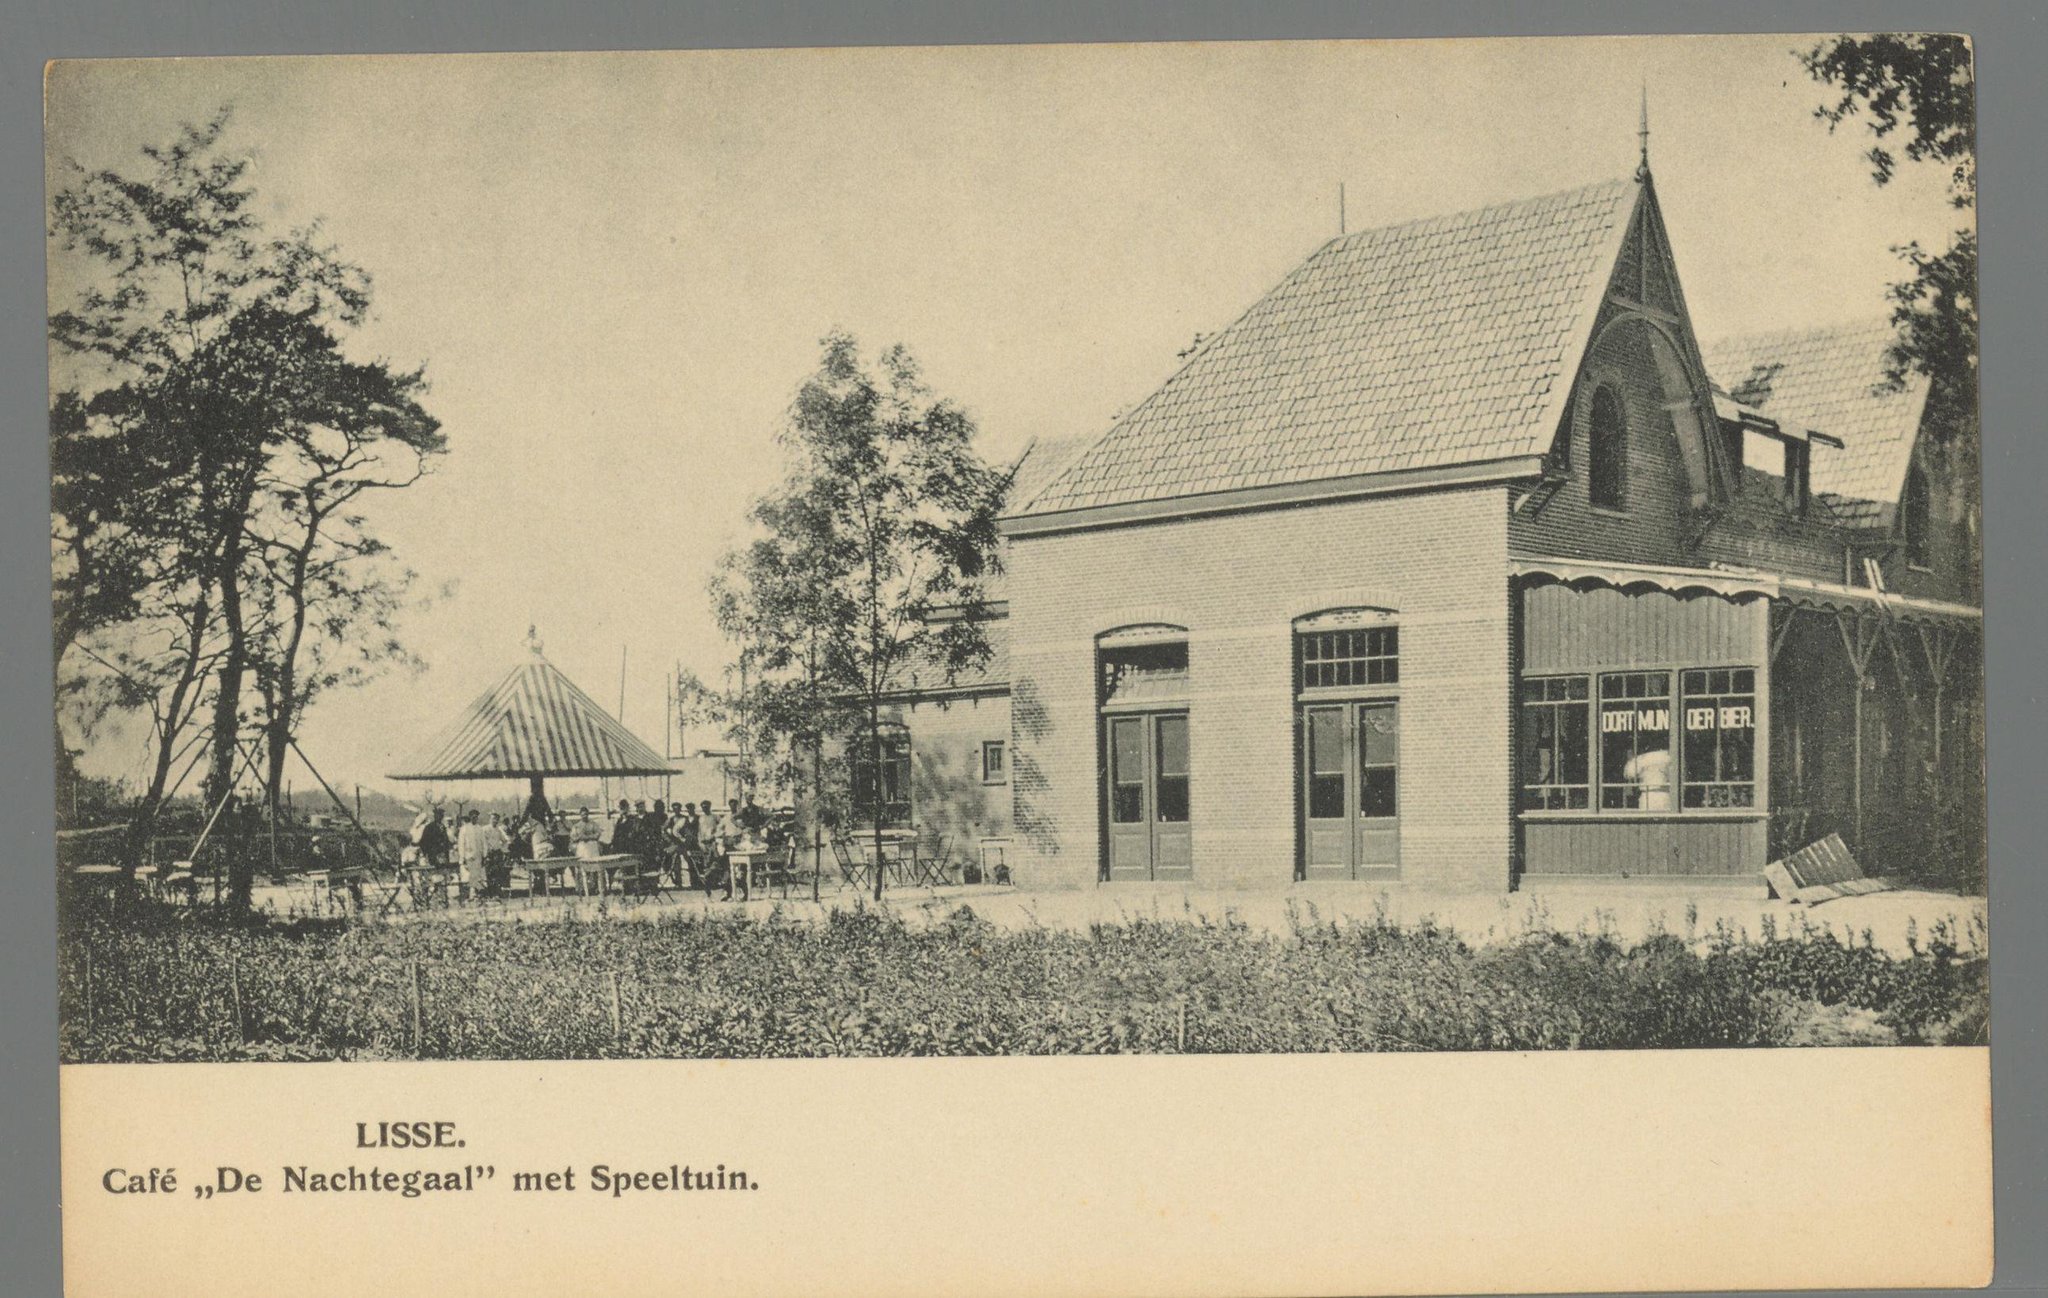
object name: ansichtkaart, prentbriefkaart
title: Lisse. Café "De Nachtegaal" met speeltuin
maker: Anonymous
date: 1897-1905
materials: cardboard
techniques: photograph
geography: lisse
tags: inn, coffee-house, public house, etc., restaurant, playground